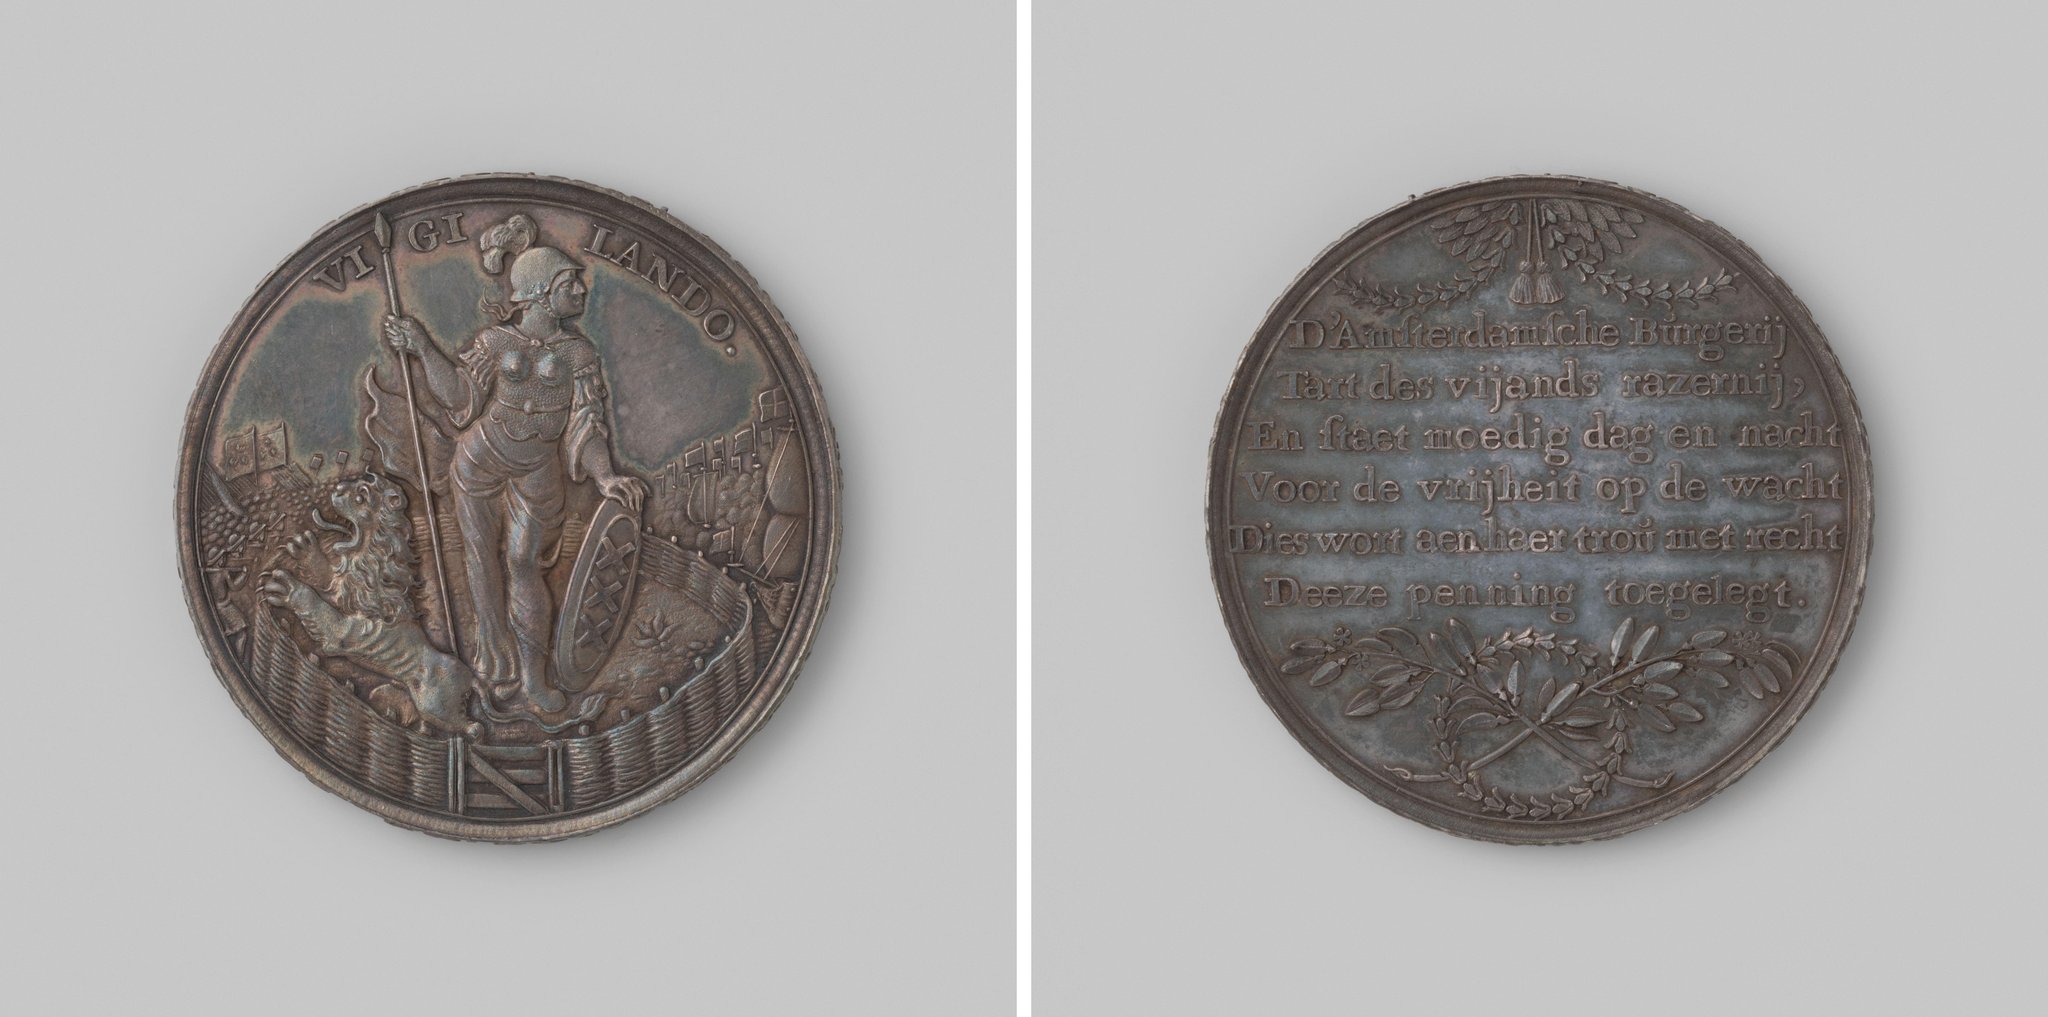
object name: history medal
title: Gedenkpenning te Amsterdam, door de magistraat aan kapitein Jan Six en zijn schutters uitgereikt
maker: Anonymous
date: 1672-1673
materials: silver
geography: amsterdam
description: Zilveren gedenkpenning. Voorzijde: de Amsterdamse Stedemaagd met helm, gewapend met speer en schild en met de Nederlandse leeuw binnen de goed gesloten Hollandse tuin, het vijandelijke leger en de vloot in het gezicht. Omschrift: VIGILANDE (Voor het waken). Keerzijde: d' Amsterdamsche burgerij/ Tart des vijands razernij,/ En staet moedig dag en nacht/ Voor de Vrijheit op de wacht,/ Dies wort aen haer troû met recht/ Deeze penning toegelegt. Hieronder een lauwerkrans met twee zegetakken. Volgens het randschrift uitgereikt aan de schutters onder kapitein Jan Six in het jaar 1673.